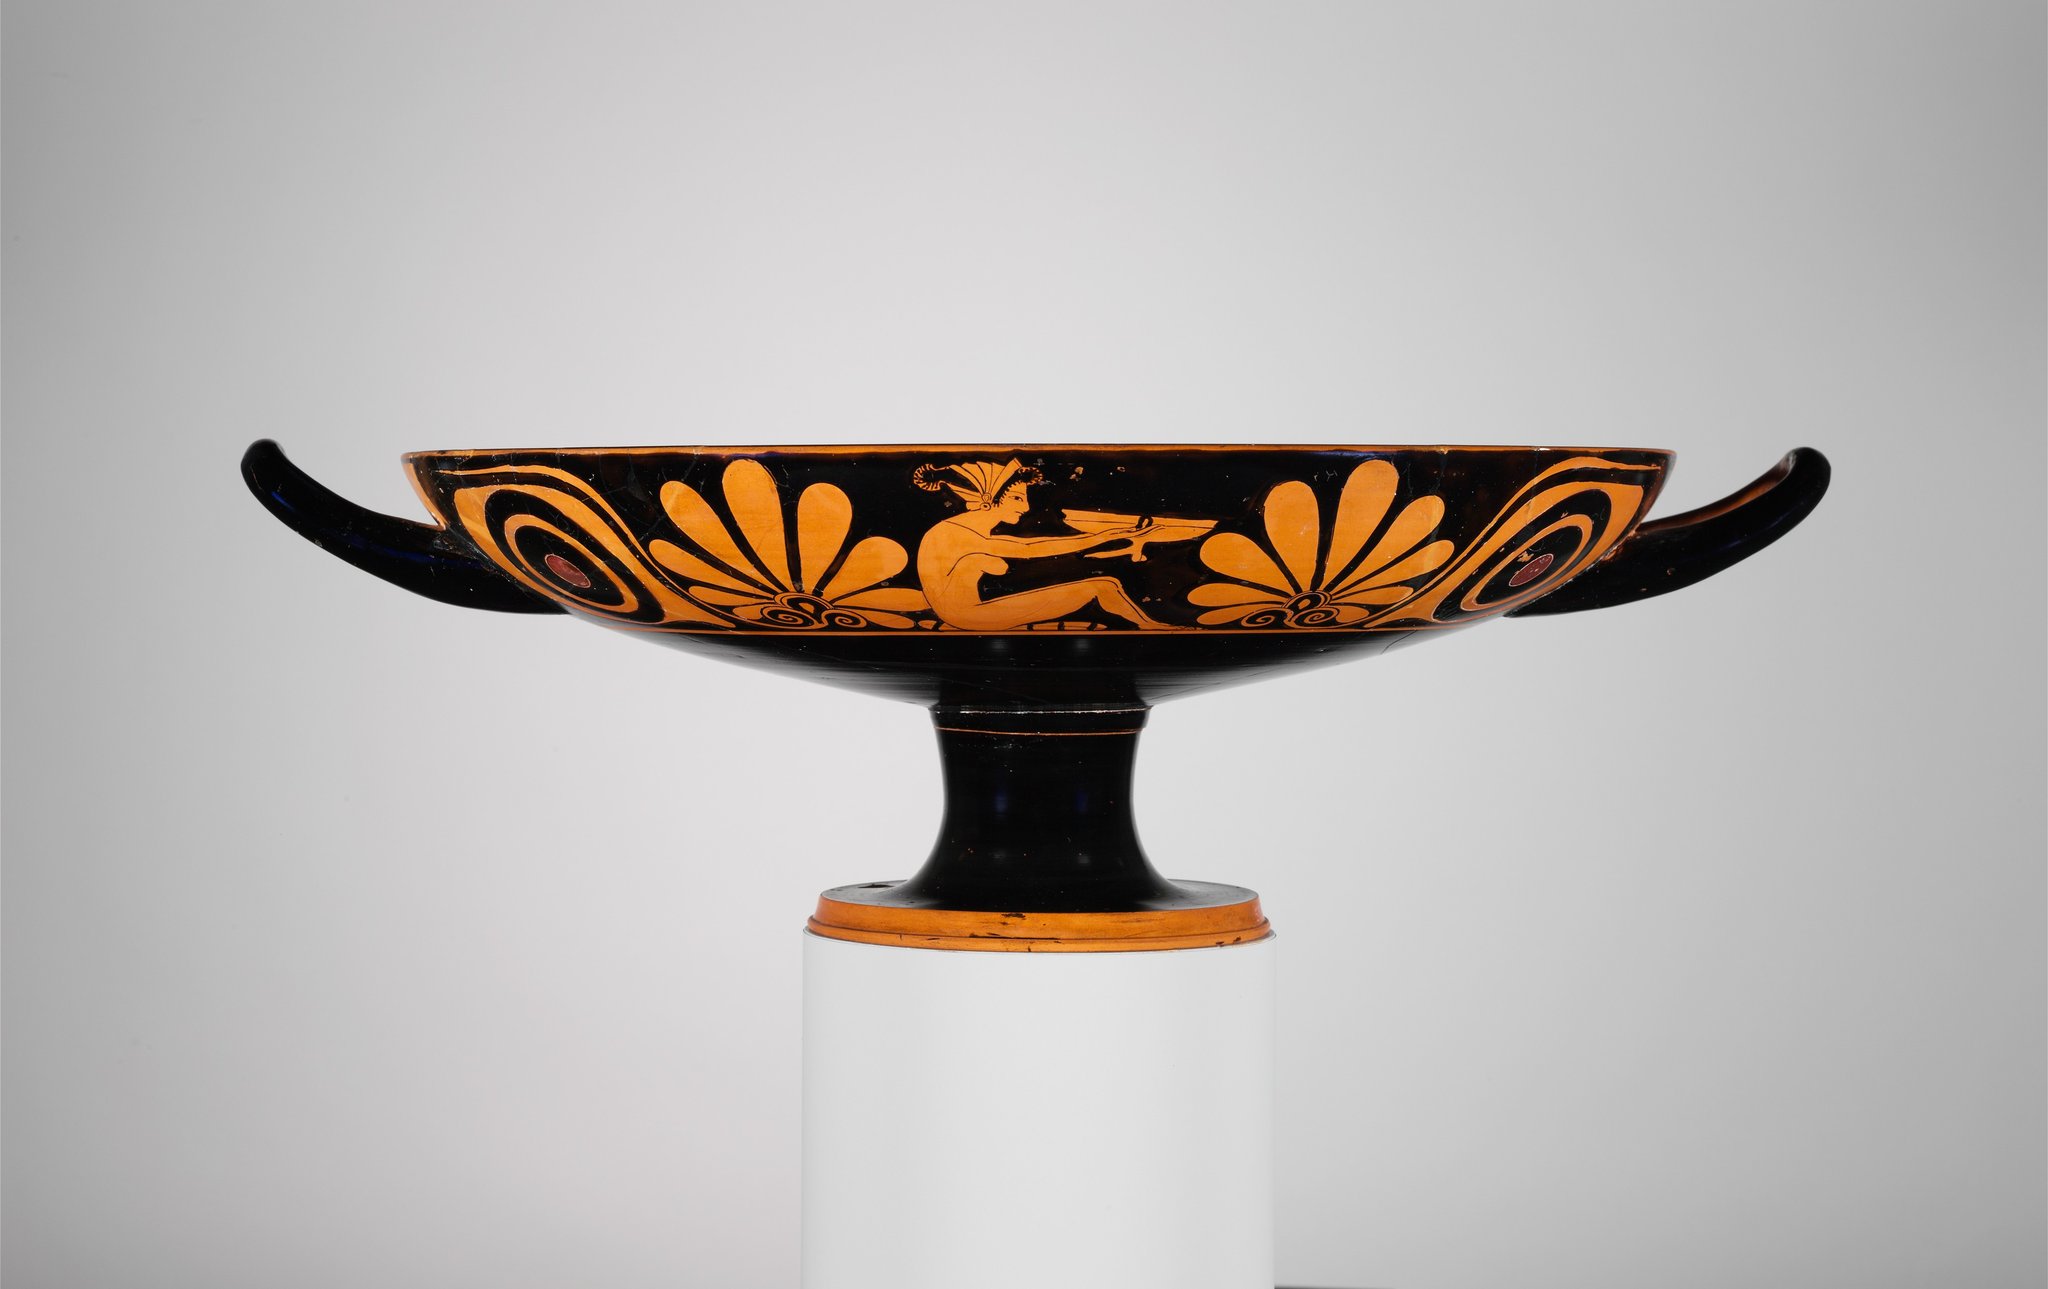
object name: kylix, eye cup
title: Terracotta kylix (drinking cup)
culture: greek, attic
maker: palmette eye-cups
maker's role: artist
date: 510 BCE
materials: terracotta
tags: men,female nudes